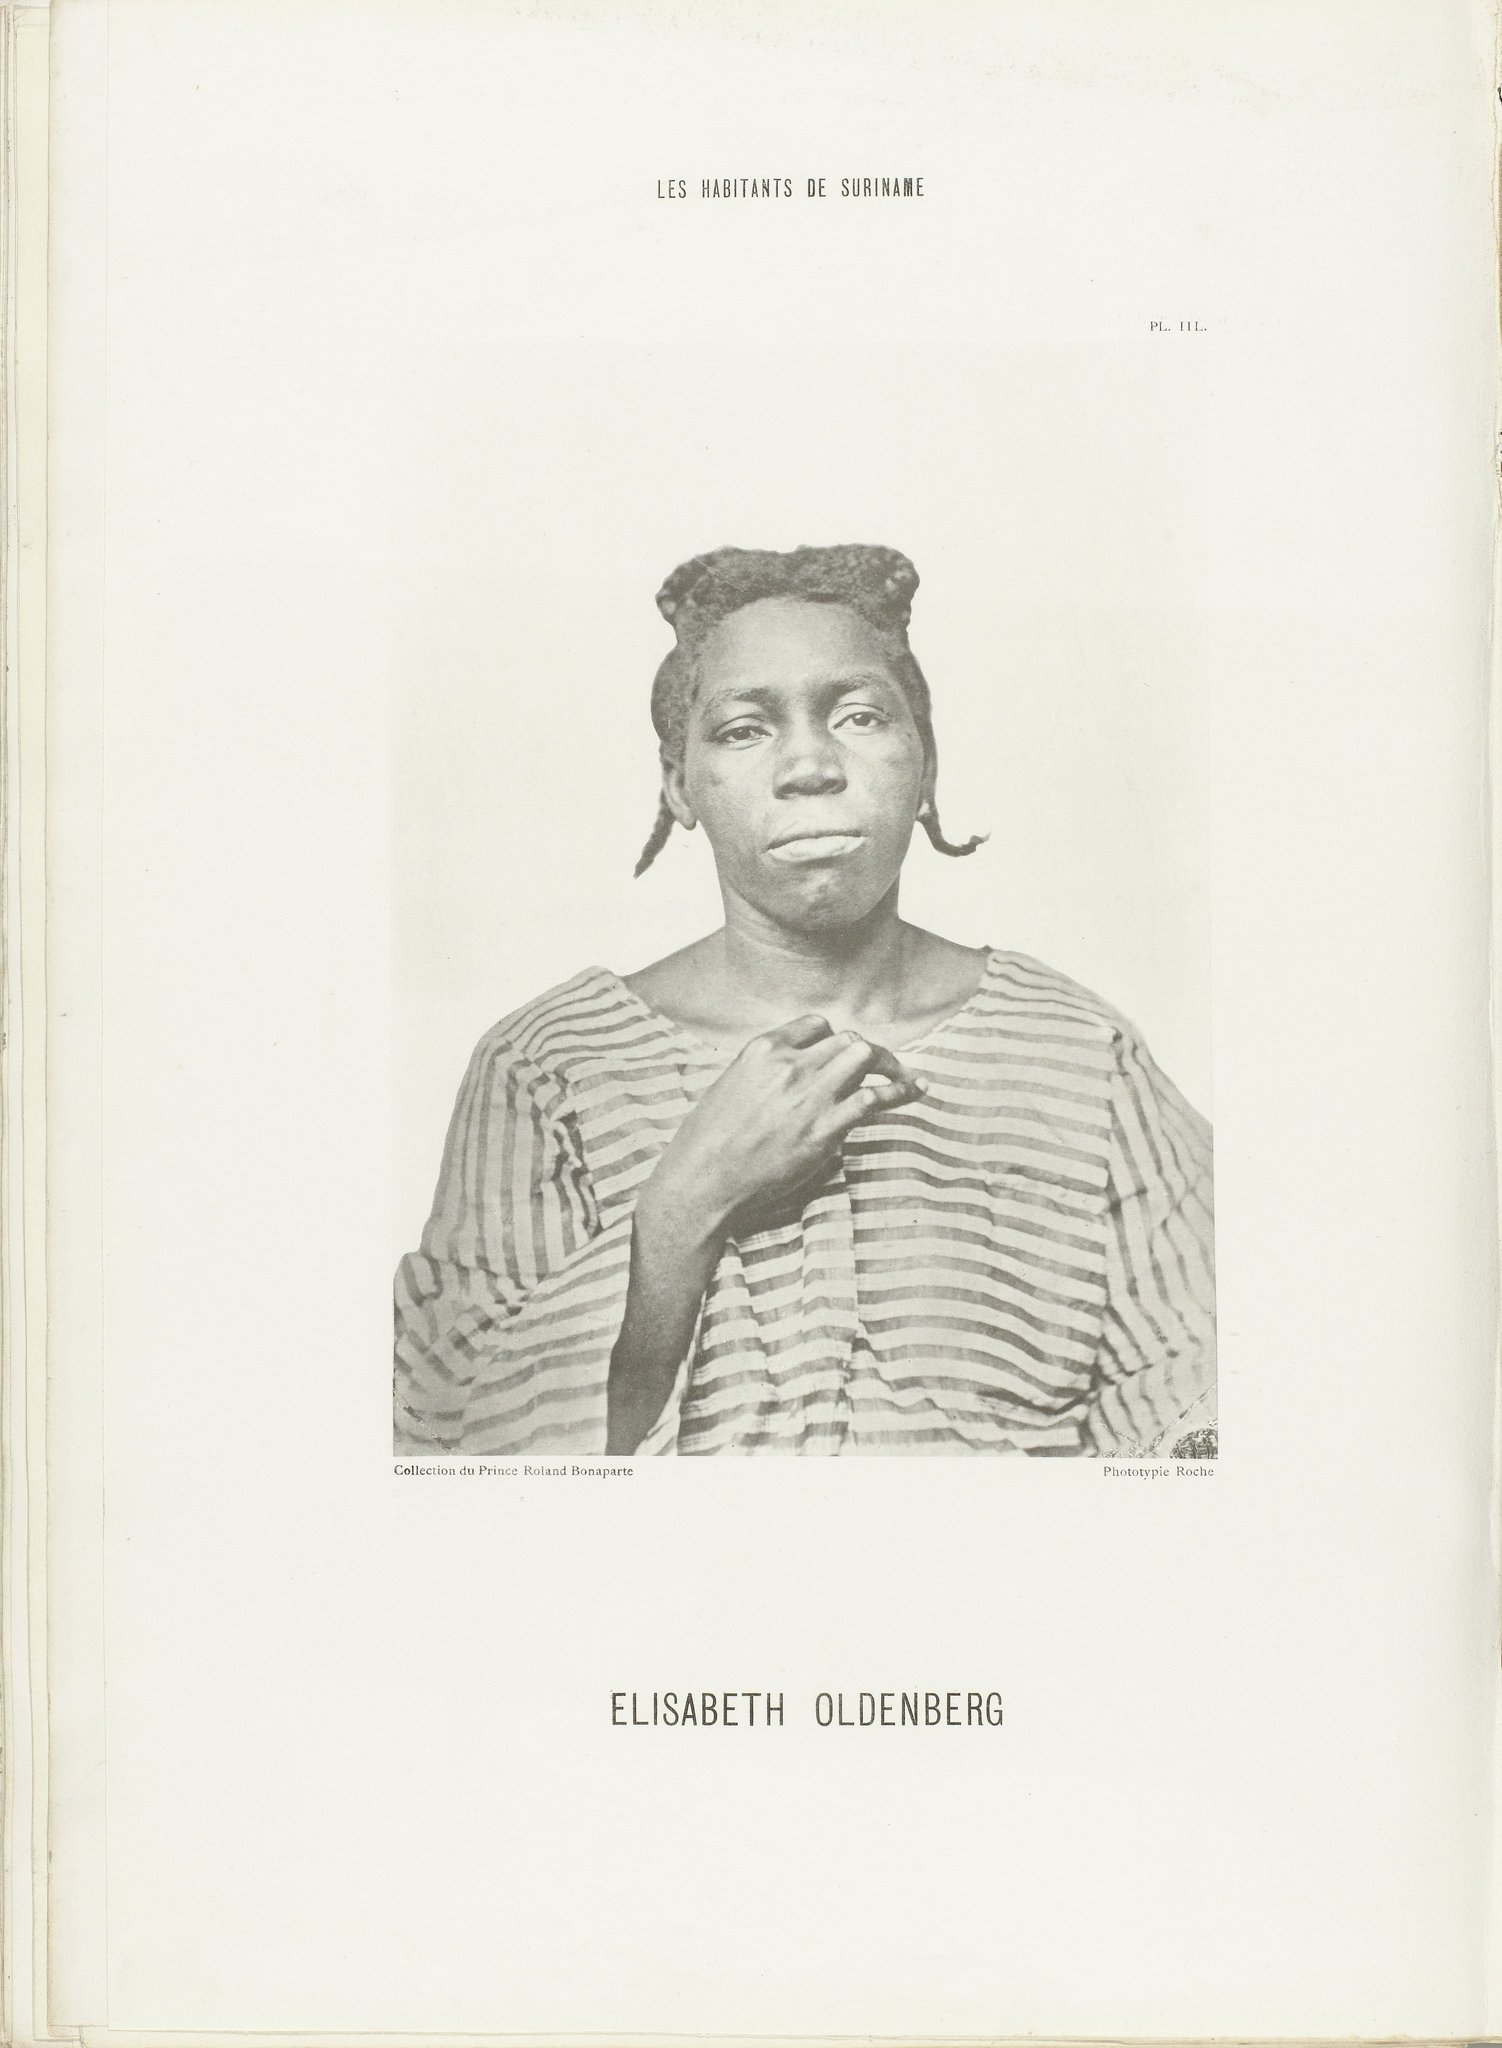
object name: page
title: Portret van Elisabeth Oldenberg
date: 1883-1884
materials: paper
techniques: photograph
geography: amsterdam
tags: adult woman, historical persons, amsterdam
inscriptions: inscription: ‘Collection du Prince Roland Bonaparte/ Phototypie Roche’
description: Portret van Elisabeth Oldenberg, een Surinaamse vrouw van Afrikaanse oorsprong, gefotografeerd op de Internationale Koloniale en Uitvoerhandel Tentoonstelling, Amsterdam 1883.